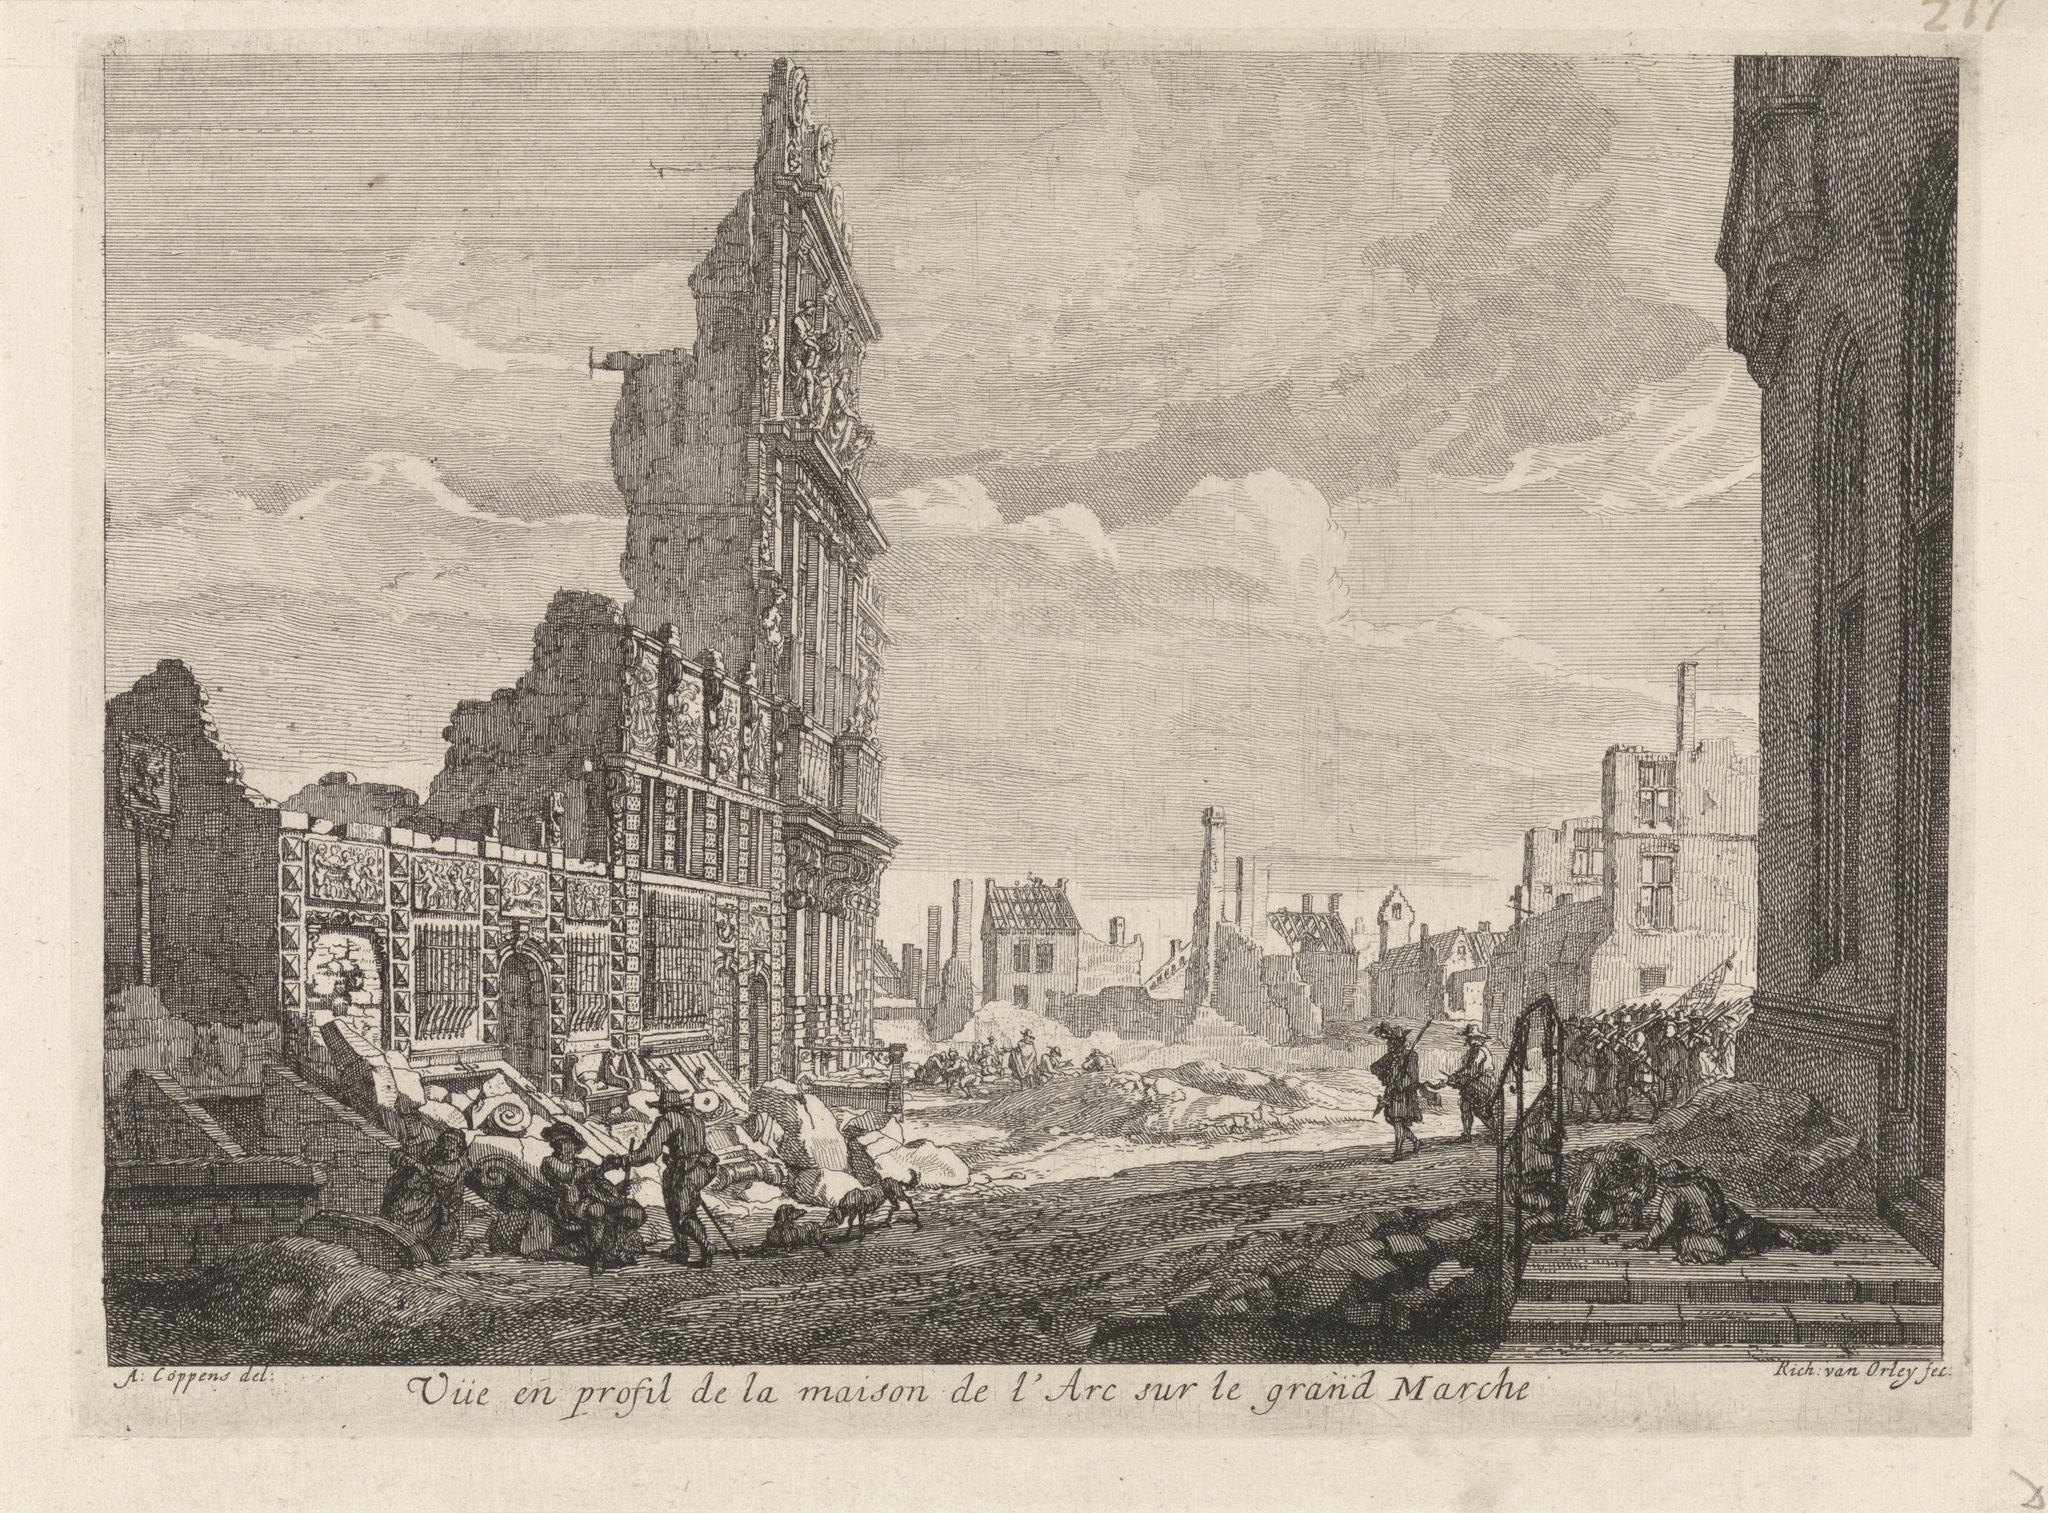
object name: print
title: Vue en profil de la maison de l'Arc sur le grand Marche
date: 1695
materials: paper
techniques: etching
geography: southern netherlands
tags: devastated, ruined place or city (~ warfare), brussels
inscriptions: collector's mark: Lugt 2228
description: Voorstelling van de ruïnes van Brussel bij de Grote Markt na het bombardement door de Fransen, 13-15 augustus 1695. Vijfde prent in de reeks van twaalf.